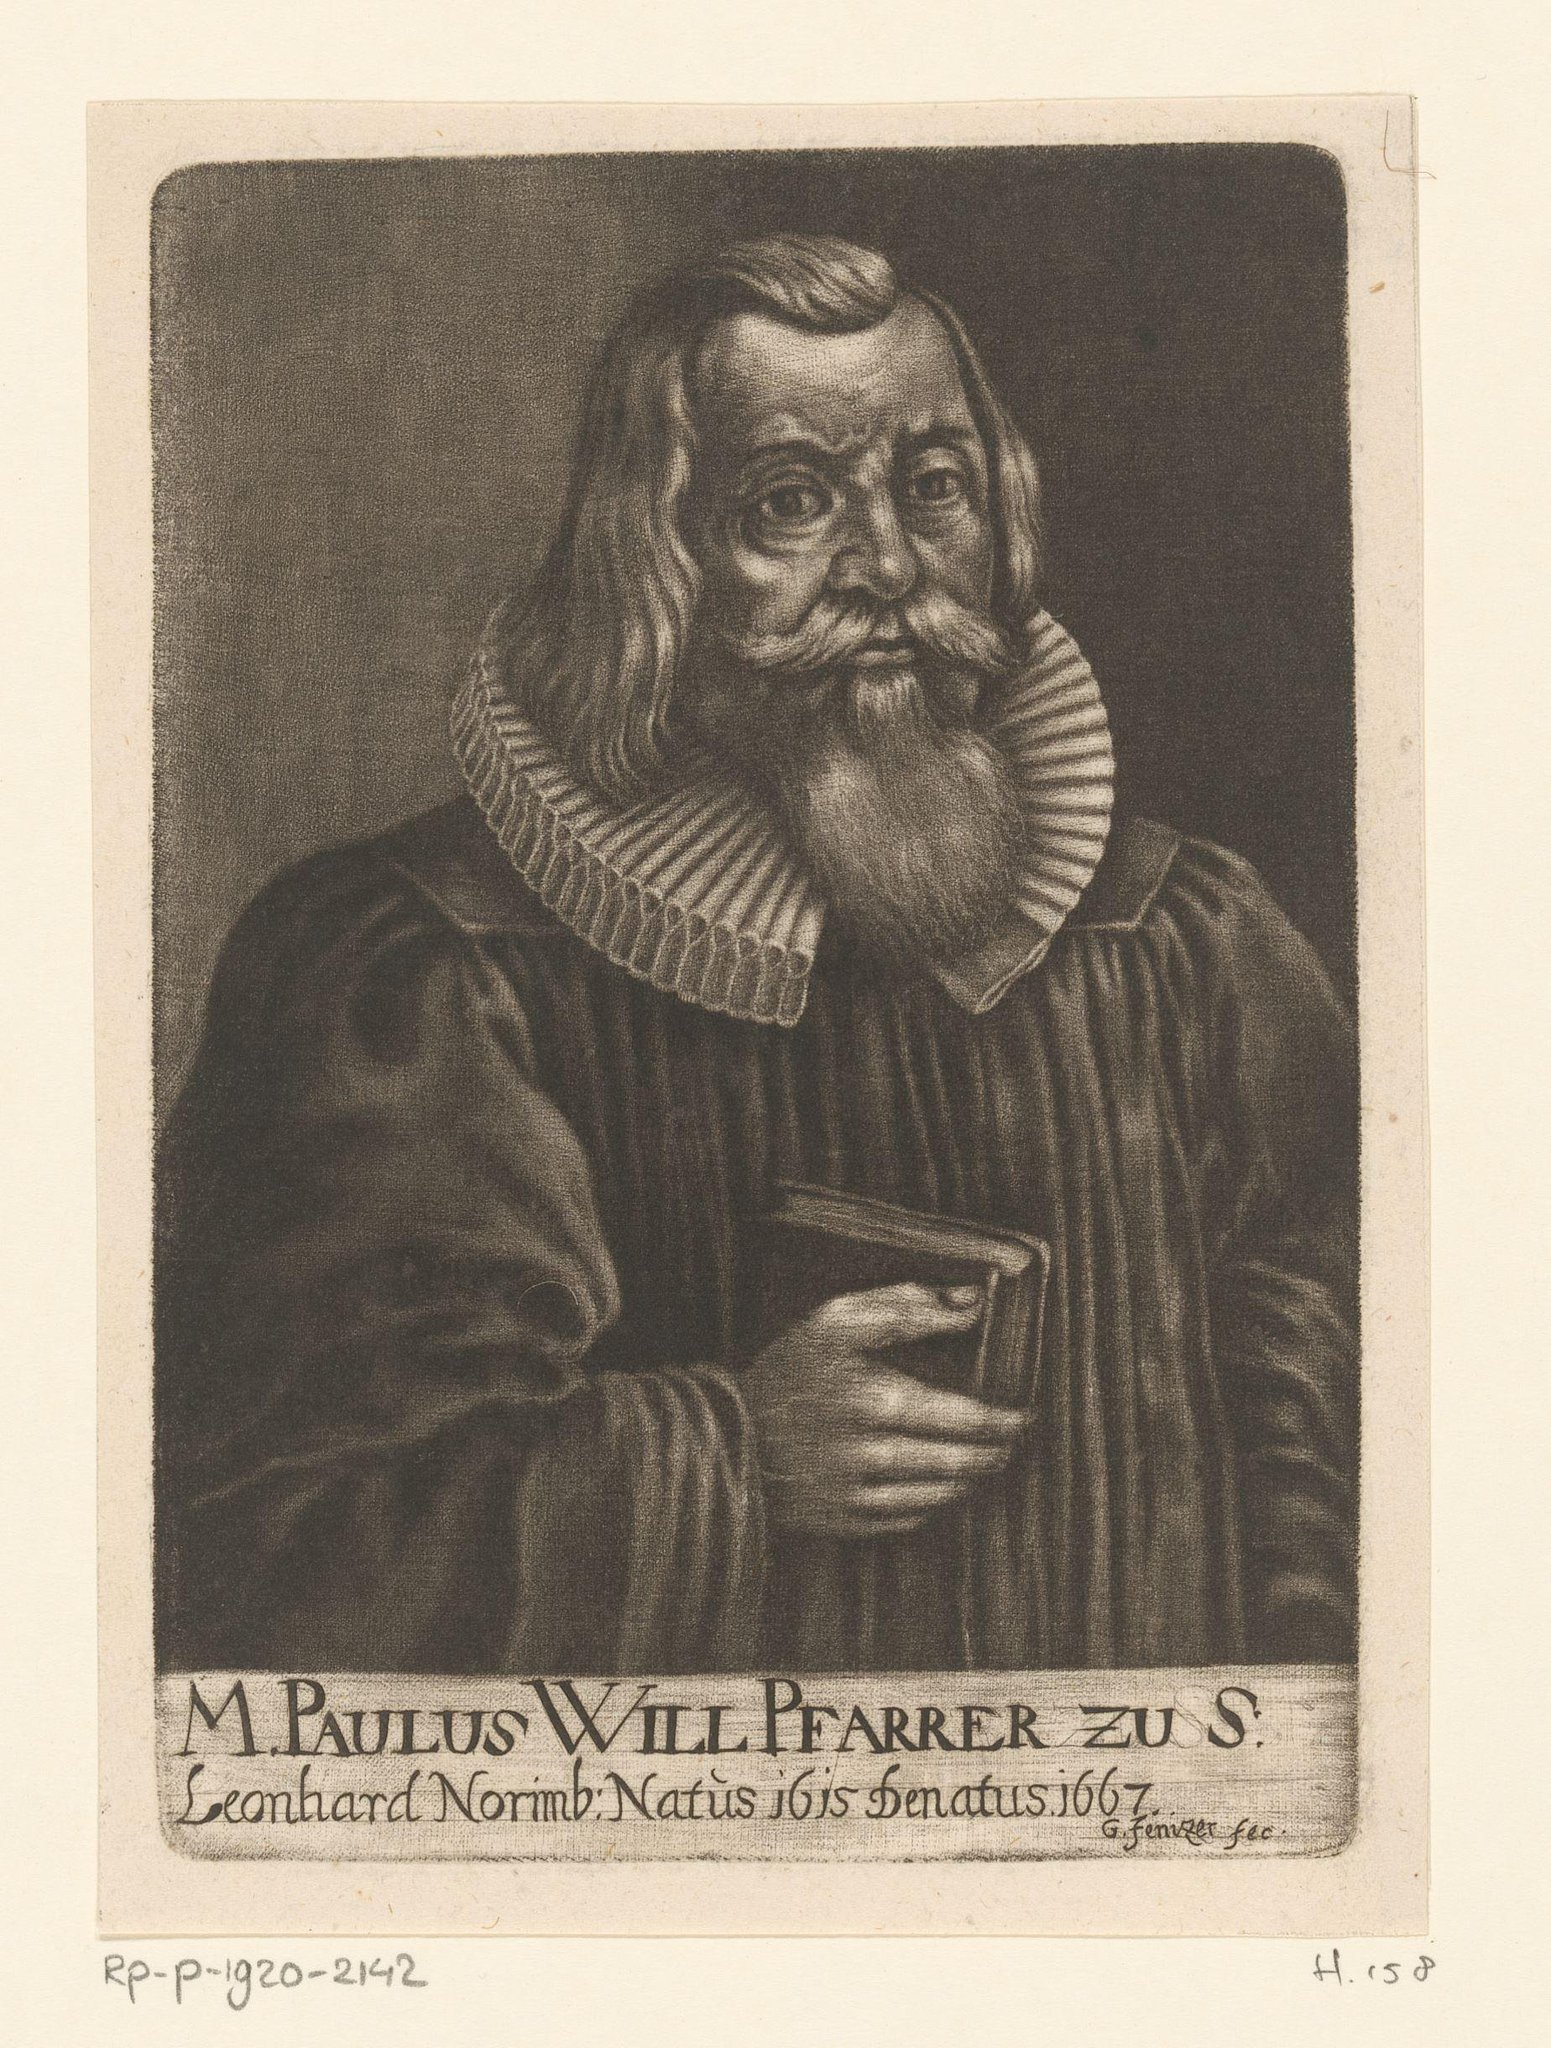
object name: print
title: Portret van Paul Will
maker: georg fennitzer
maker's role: print maker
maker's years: 1646-1722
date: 1667-1722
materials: paper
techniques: mezzotint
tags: historical persons, book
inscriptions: collector's mark: Lugt 2228